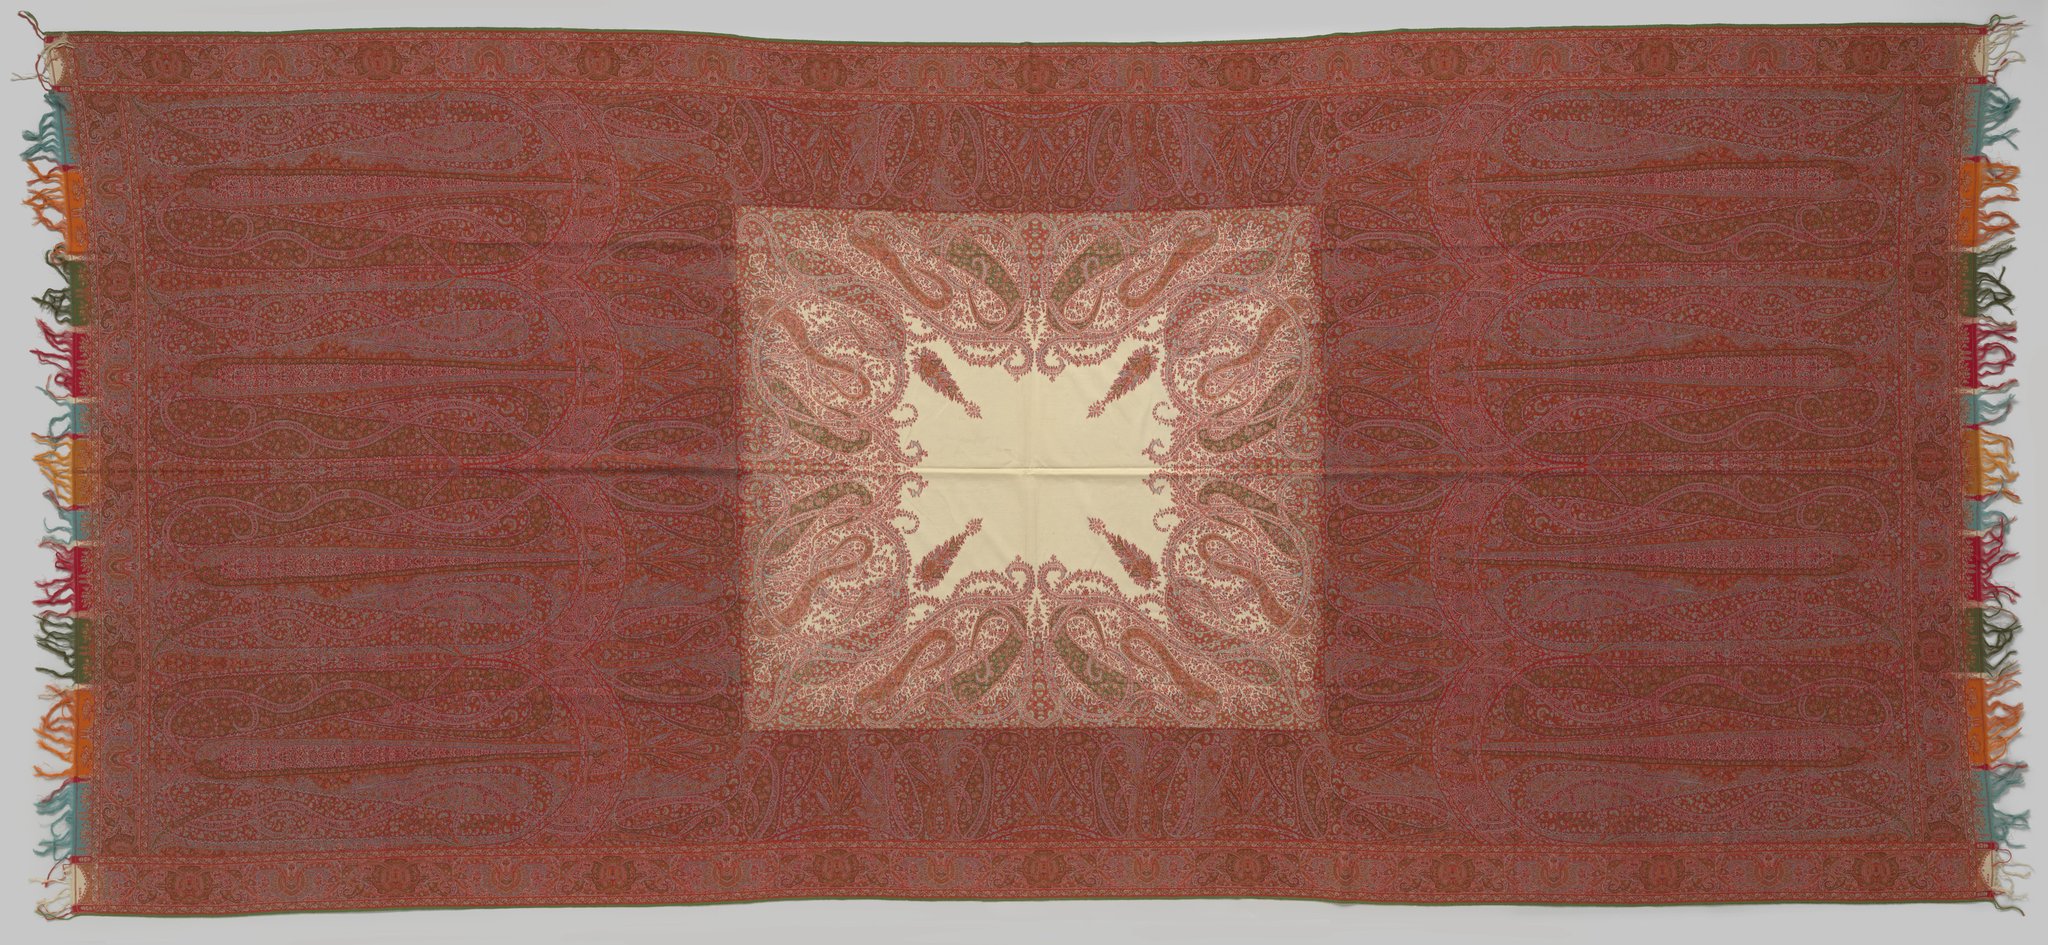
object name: bruidssjaal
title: Langwerpige sjaal met rechthoekig veld waarin een vierkante witte spiegel met slanke palmmotieven, de randen bestaan uit S-ranken met lelies en palmetten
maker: Anonymous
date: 1840-1844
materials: cotton, silk, wool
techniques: weave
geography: lyon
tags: w. van eyndhoven-wittich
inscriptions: label: ‘'IP', '36725', '2425', '18454', 'long' en 'blanc'’, number: ‘2425’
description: Sjaal met rechthoekig veld waarin een vierkante, witte spiegel met slanke palmmotieven, de randen bestaan uit S-ranken met lelies en palmetten. Franjes aan de korte zijden. Twee dwarspanelen met langgerekte palmmotieven, twee aan twee gerangschikt, ter weerszijden van een cypres en afgedekt door vier bogen waarboven kleinere palmmotieven staan, terwijl dit geheel door golvende ranken wordt doorsneden. De randen bestaan uit S-ranken met beurtelings een lelie en een palmet. Alle motieven zijn met een fijn bloemornament overladen. De korte zijden eindigen met franje en effen banen, die ontstaan zijn door partiële kleuring van de kettingdraden. Kleuren: rood, oranje, okergeel, groen, turquoise-blauw en wit. Weefselbinding: keper. Materiaal: zijde voor de ketting en wol voor de inslag, met katoen in de effen baantjes als versterkingsinslag.